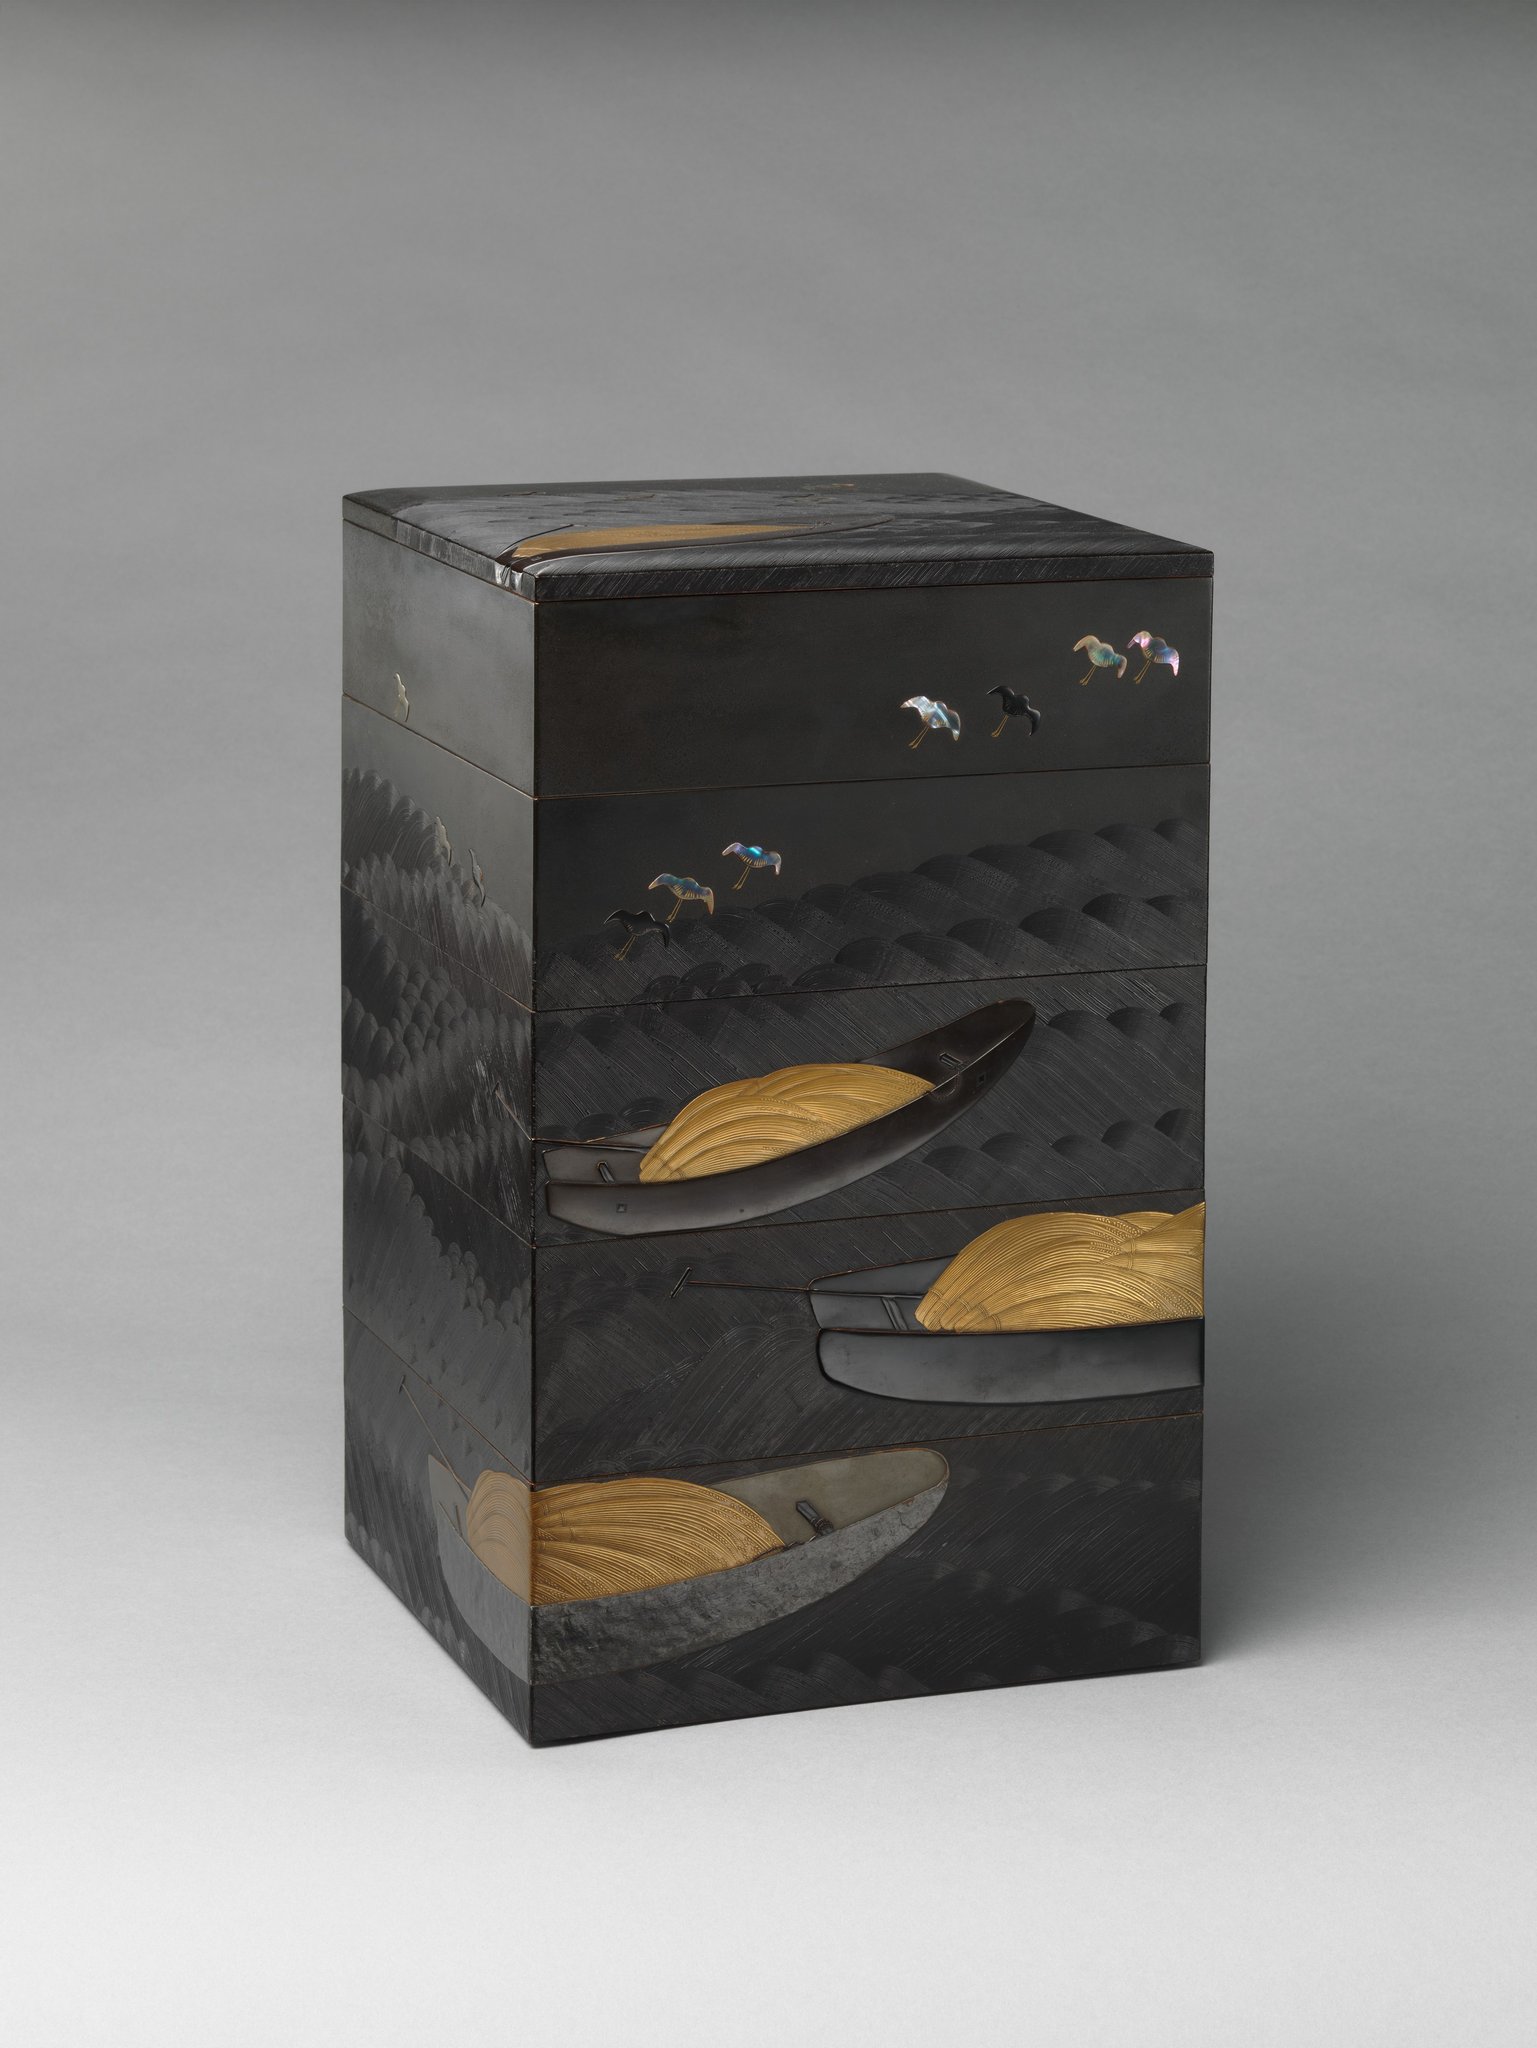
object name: box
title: Tiered Box (Jūbako) with Design of Boats and Plovers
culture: japanese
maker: shibata zeshin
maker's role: artist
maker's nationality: japanese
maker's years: 1807-1891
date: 1851-1900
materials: gold, lacquer, mother of pearl, pewter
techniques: inlay, maki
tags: birds,boats